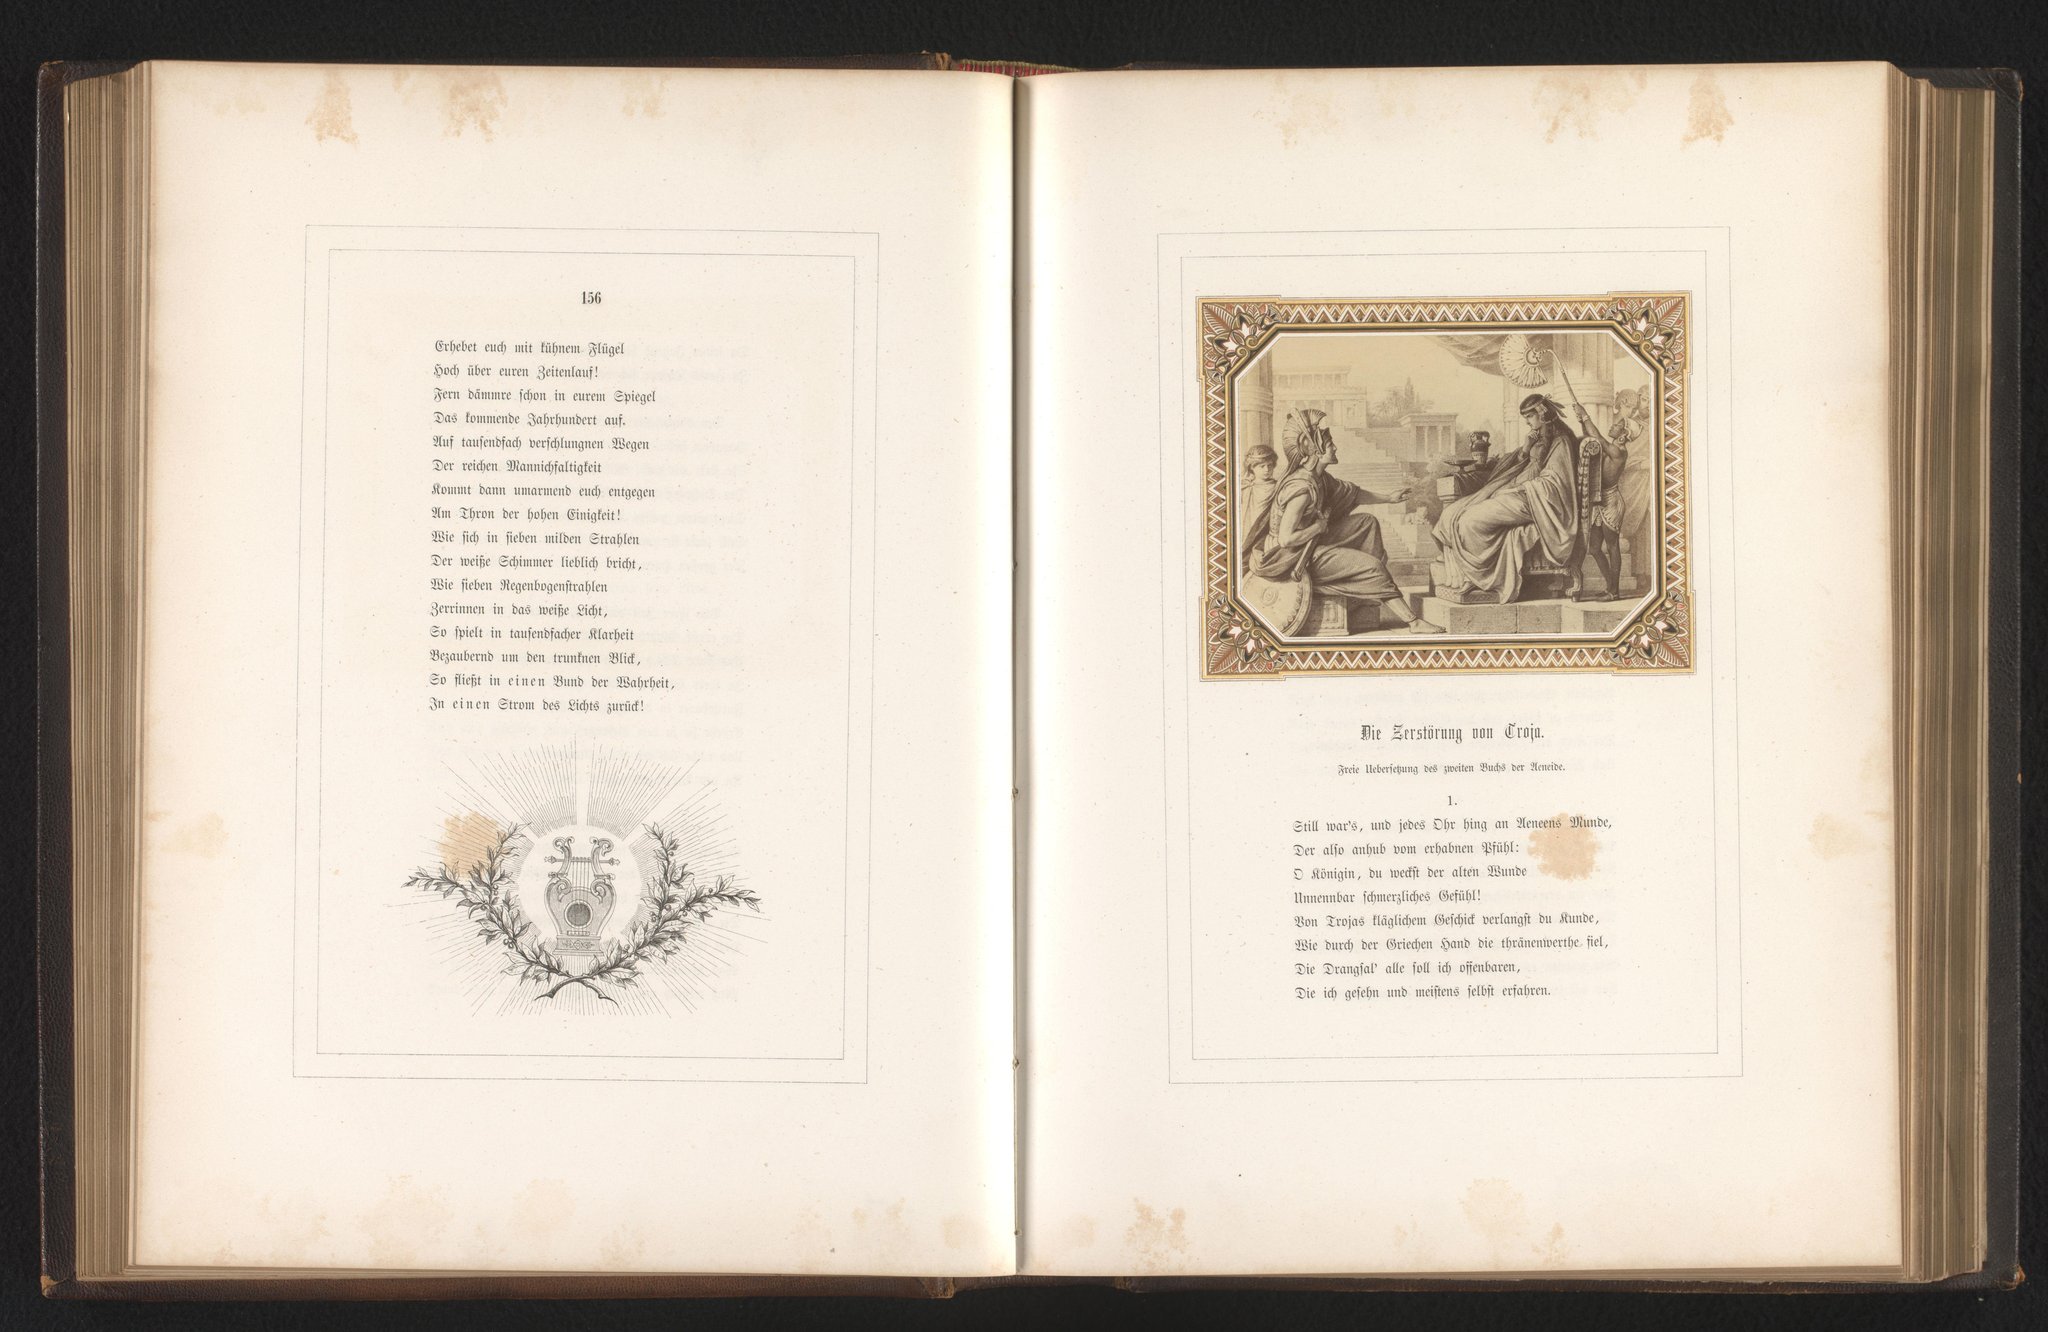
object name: reproduction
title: Ramberg: Die Verstörung von Troja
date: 1855-1862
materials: paper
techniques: albumen print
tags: aeneas tells dido of his wanderings, (story of) dido, (story of) aeneas